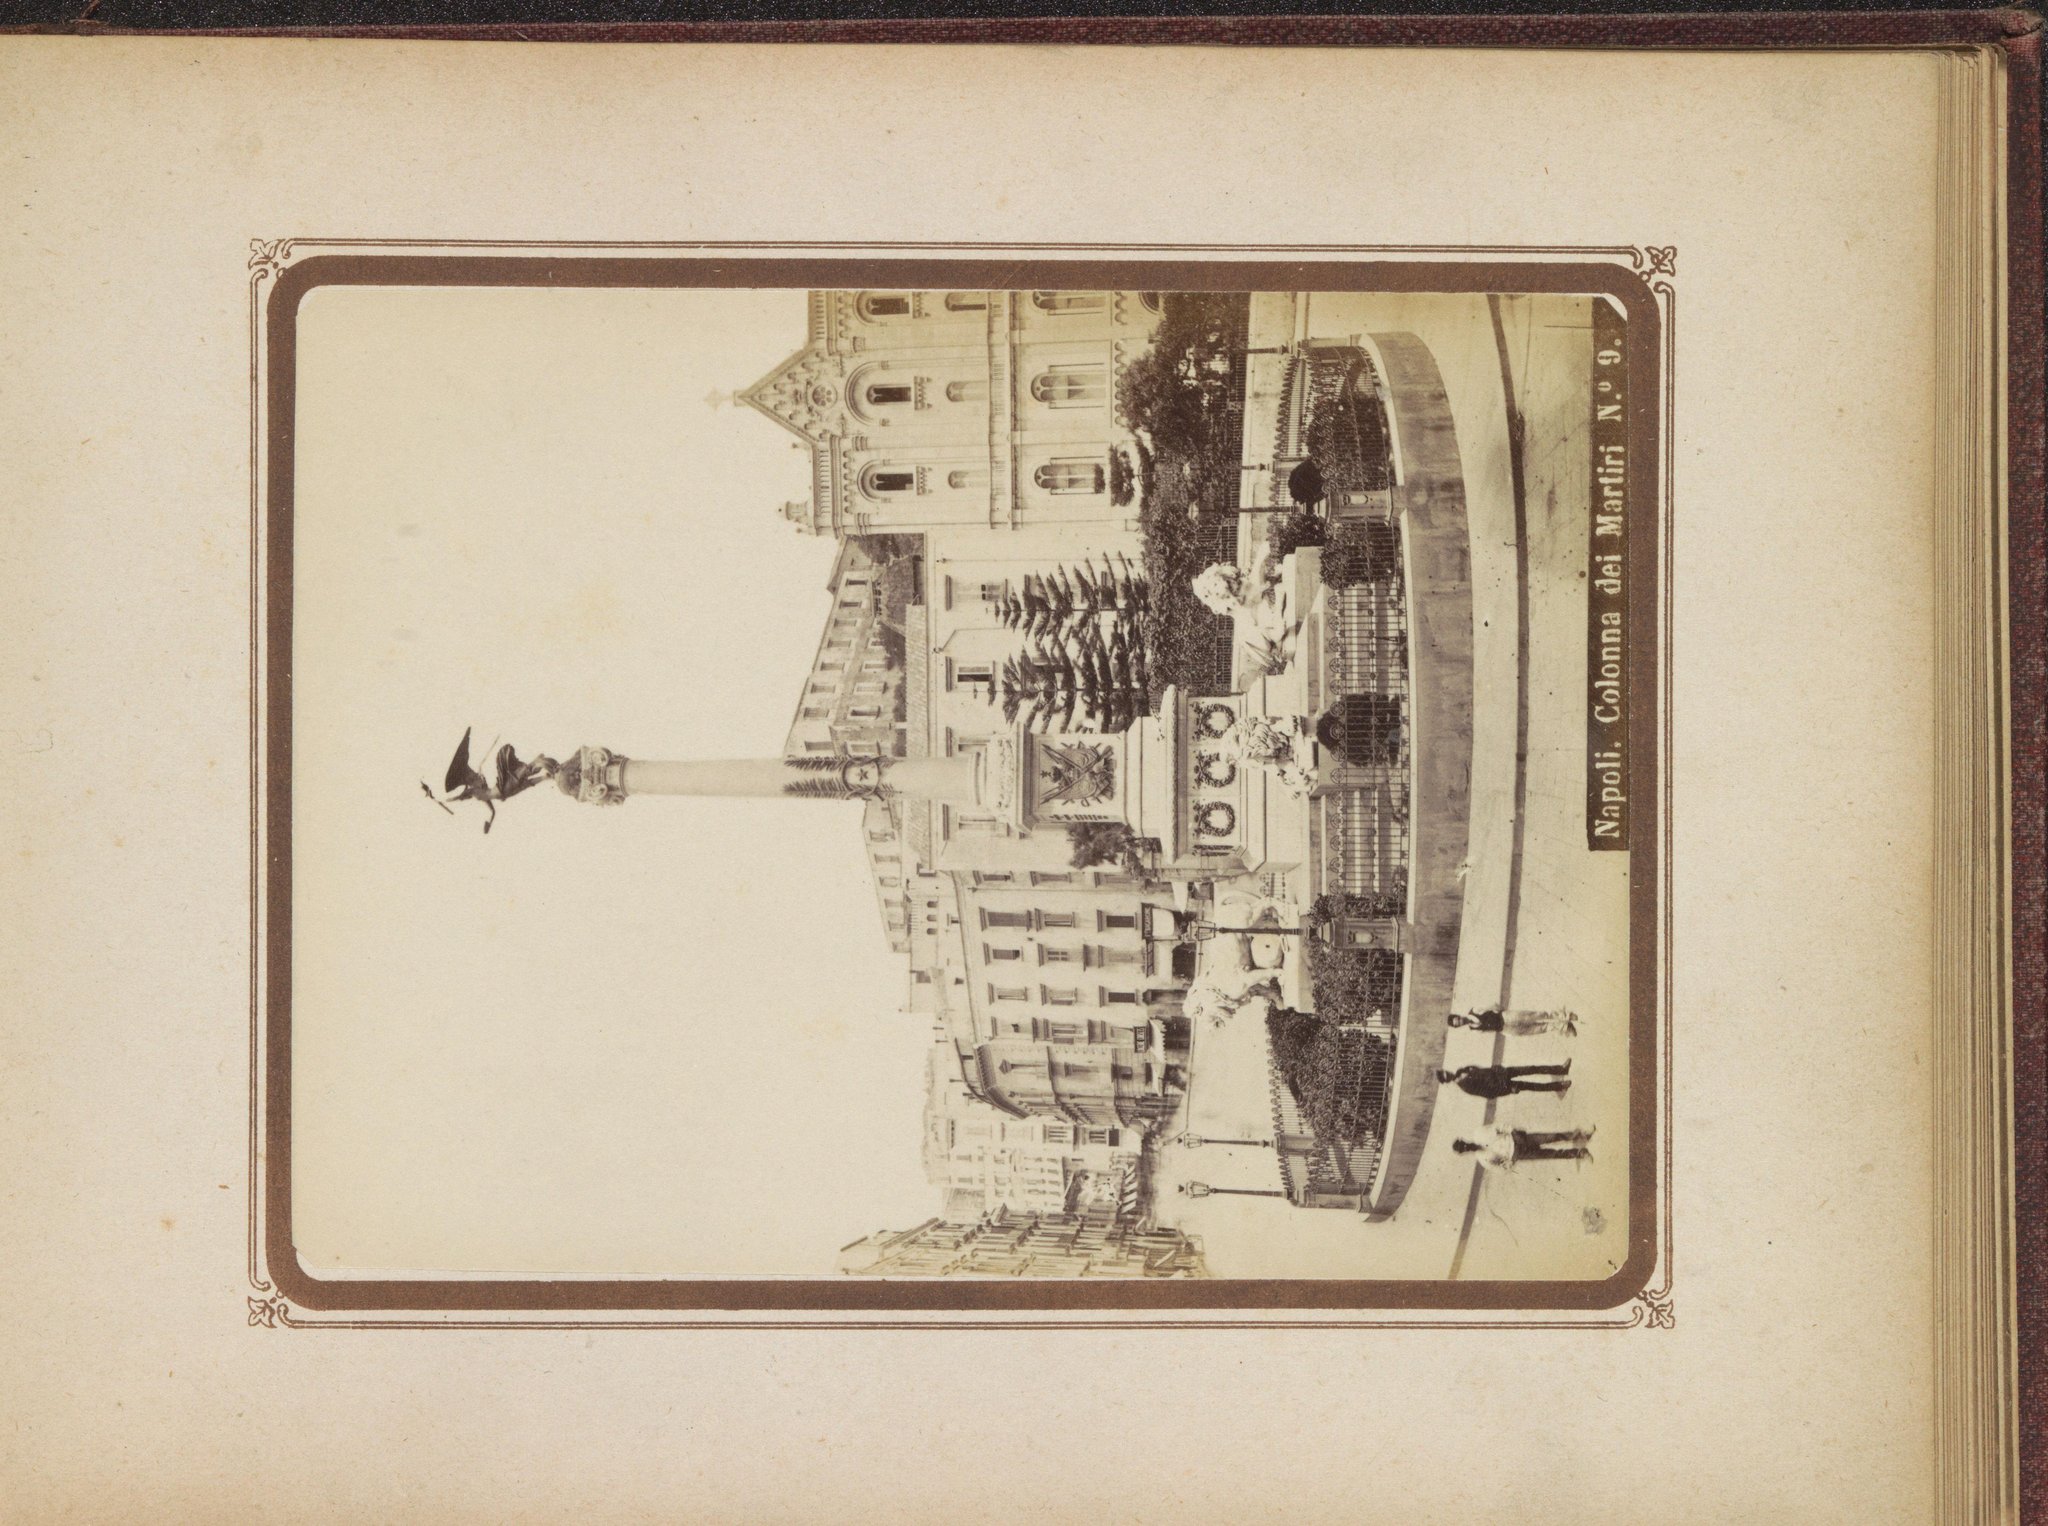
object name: photograph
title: Napoli. Colonna dei Martiri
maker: roberto rive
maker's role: fotograaf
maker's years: 1825-1868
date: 1860-1900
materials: paper, photographic support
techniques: albumen print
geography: naples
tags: monument, statue, square, place, circus, etc. (+ city(-scape) with figures, staffage), naples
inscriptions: number: ‘9’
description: Onderdeel van Fotoalbum met bezienswaardigheden in Napels en omgeving door Roberto Rive.